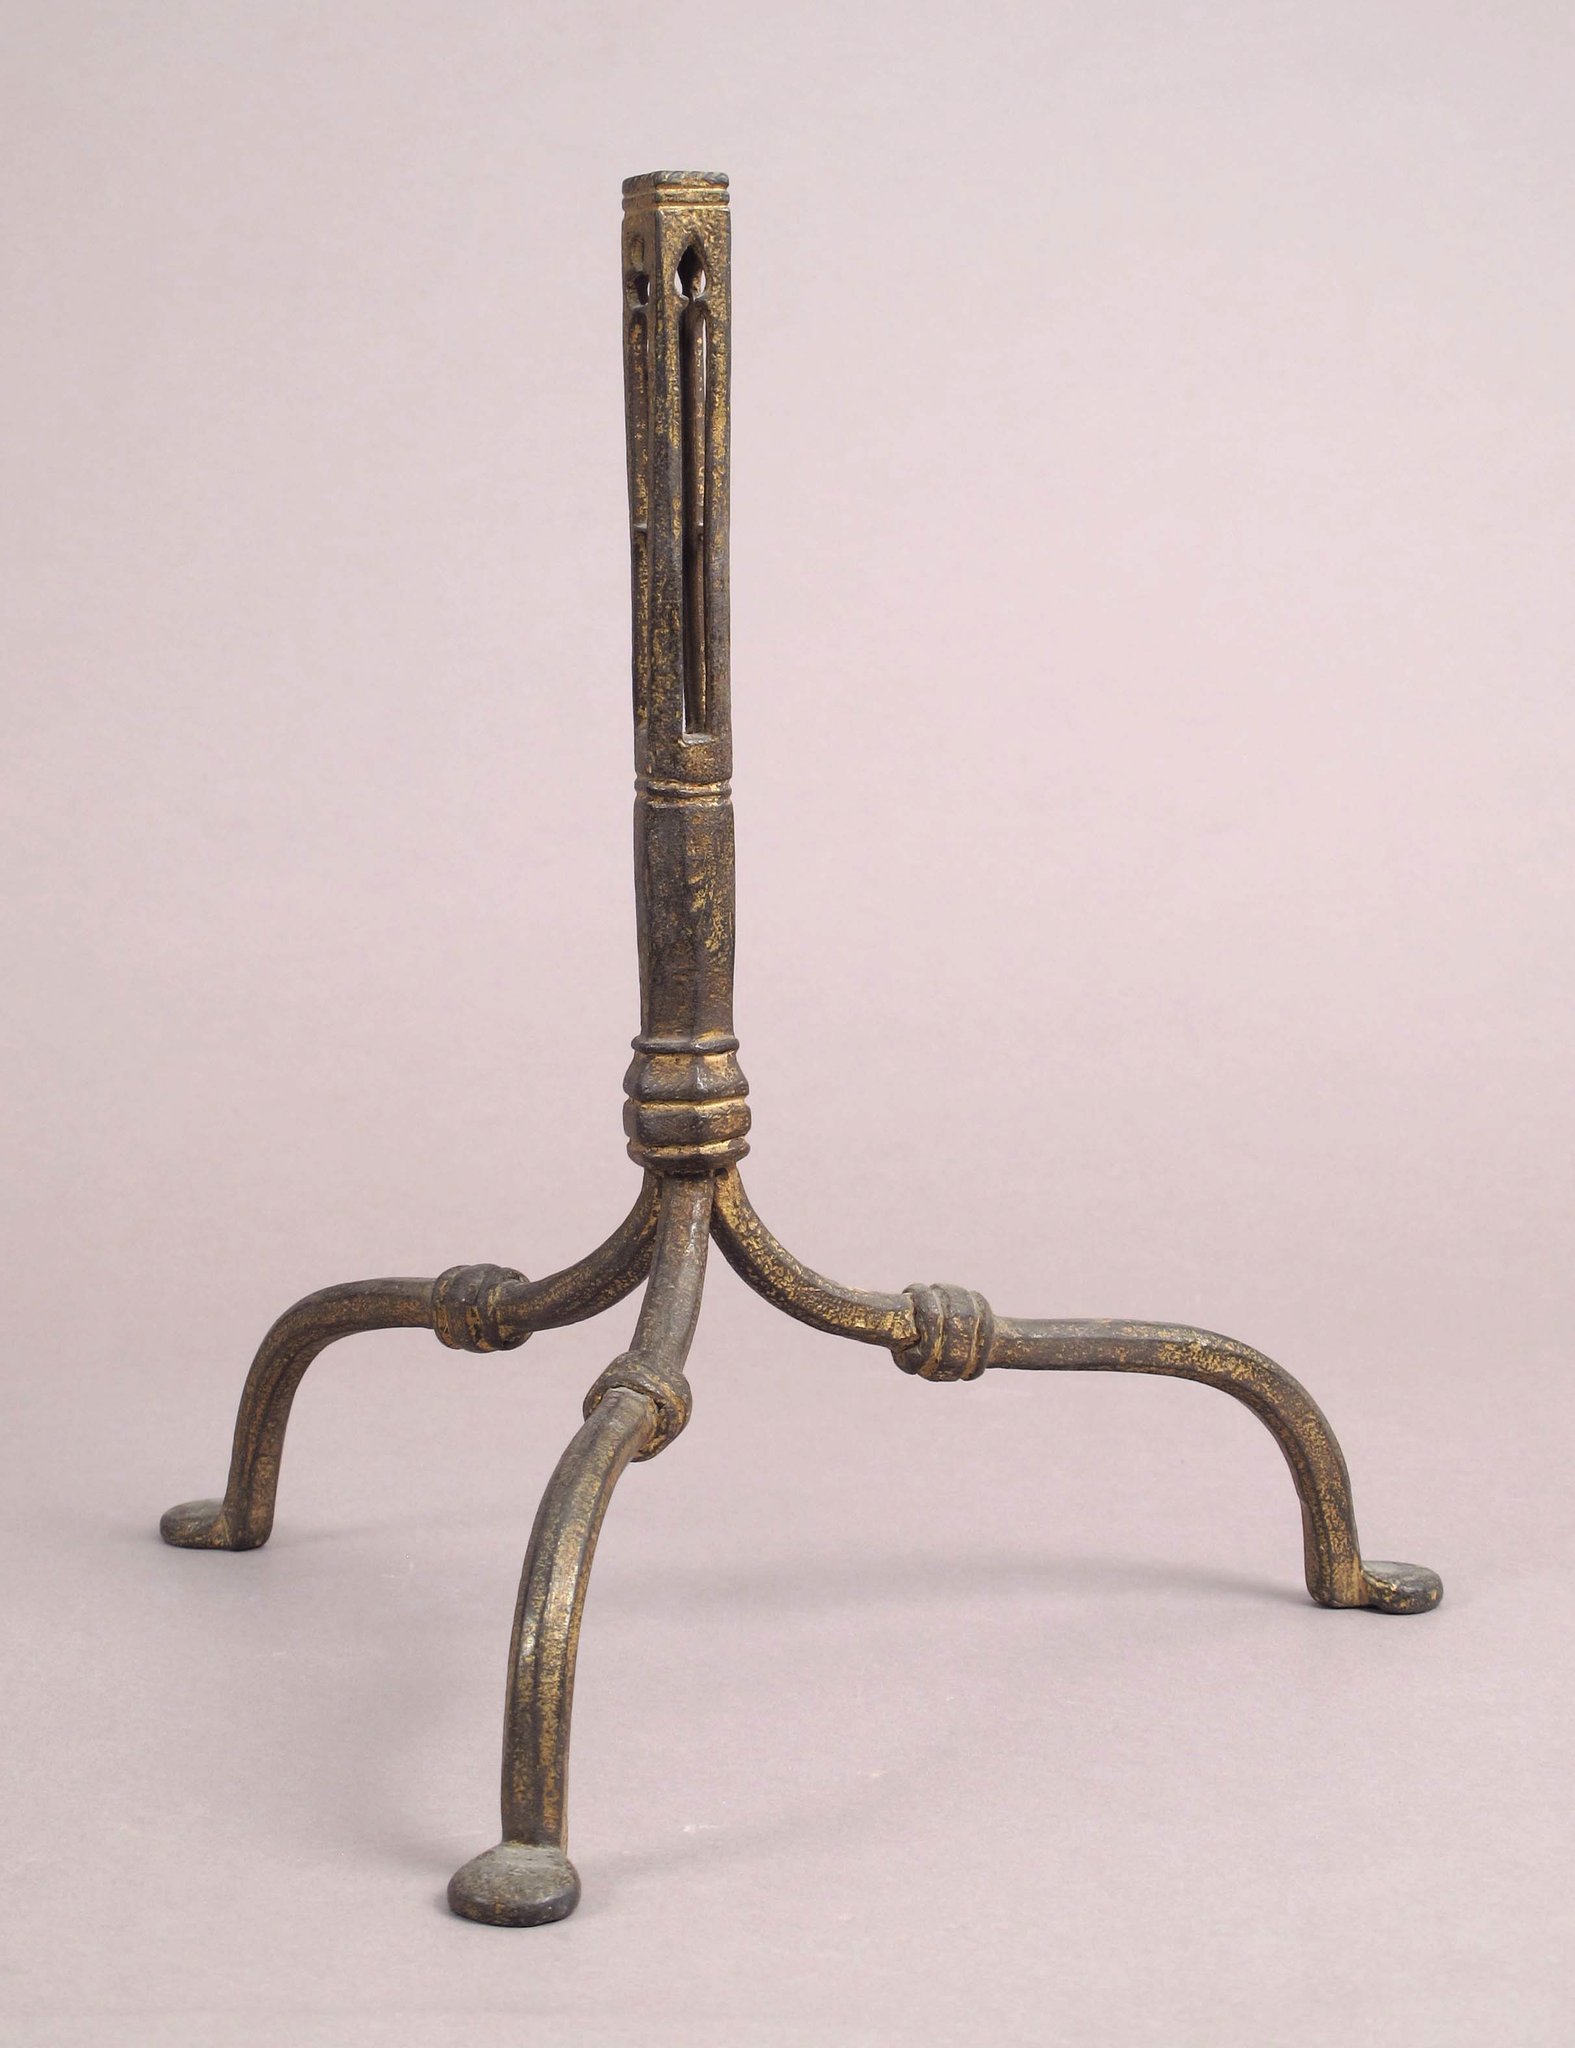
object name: tripod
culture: italian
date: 1401-1500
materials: gilt, iron